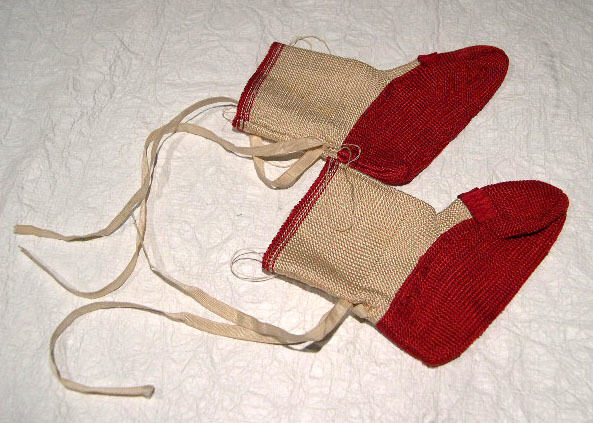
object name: sock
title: Socks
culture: american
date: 1840-1849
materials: silk